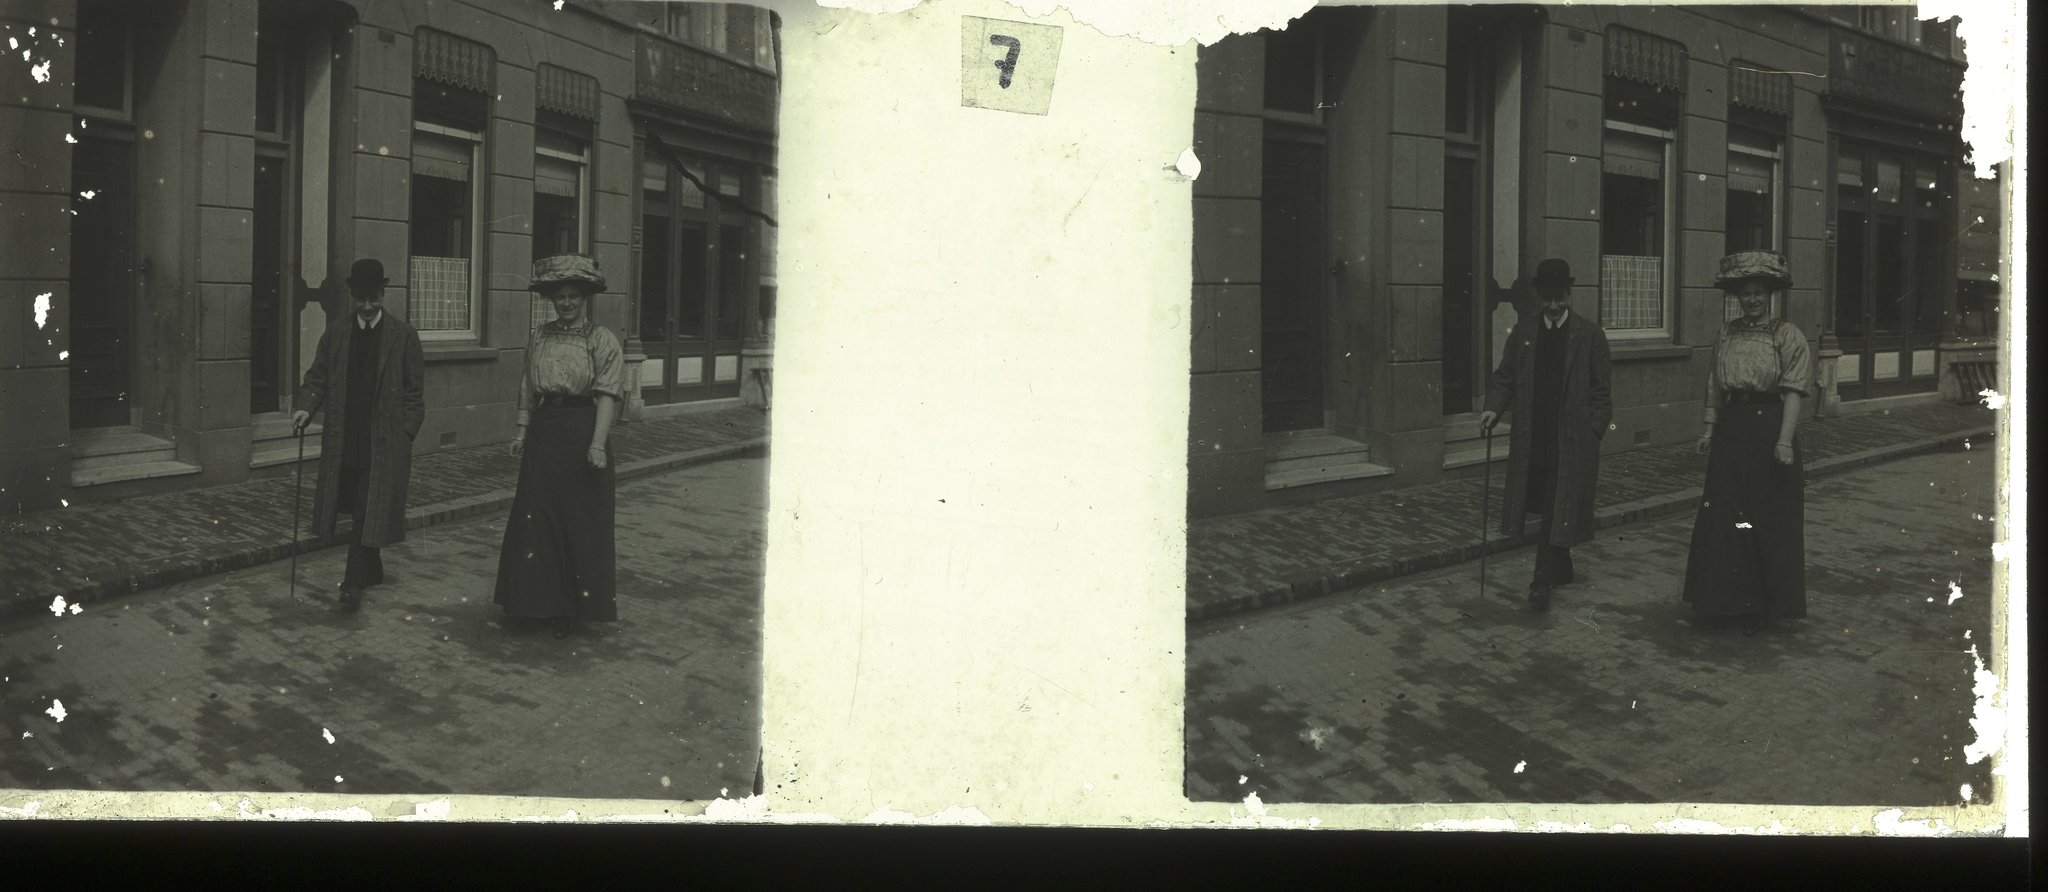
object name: stereograph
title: Man en vrouw in Nederland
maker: theodoor brouwers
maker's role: amateurfotograaf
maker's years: 1874-1932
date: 1913-1930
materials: glass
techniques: photography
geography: netherlands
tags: amsterdam, theodoor brouwers, netherlands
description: In de periode 1911-1932 woonde op plantage Accaribo in Suriname de familie Brouwers van wie de foto's afkomstig zijn. Rond 1910 vond Theodoor Brouwers werk op plantage Accaribo. In 1929 werd hij eigenaar van de plantage. Op Accaribo werden in zijn tijd bananen geproduceerd en wat koffie.